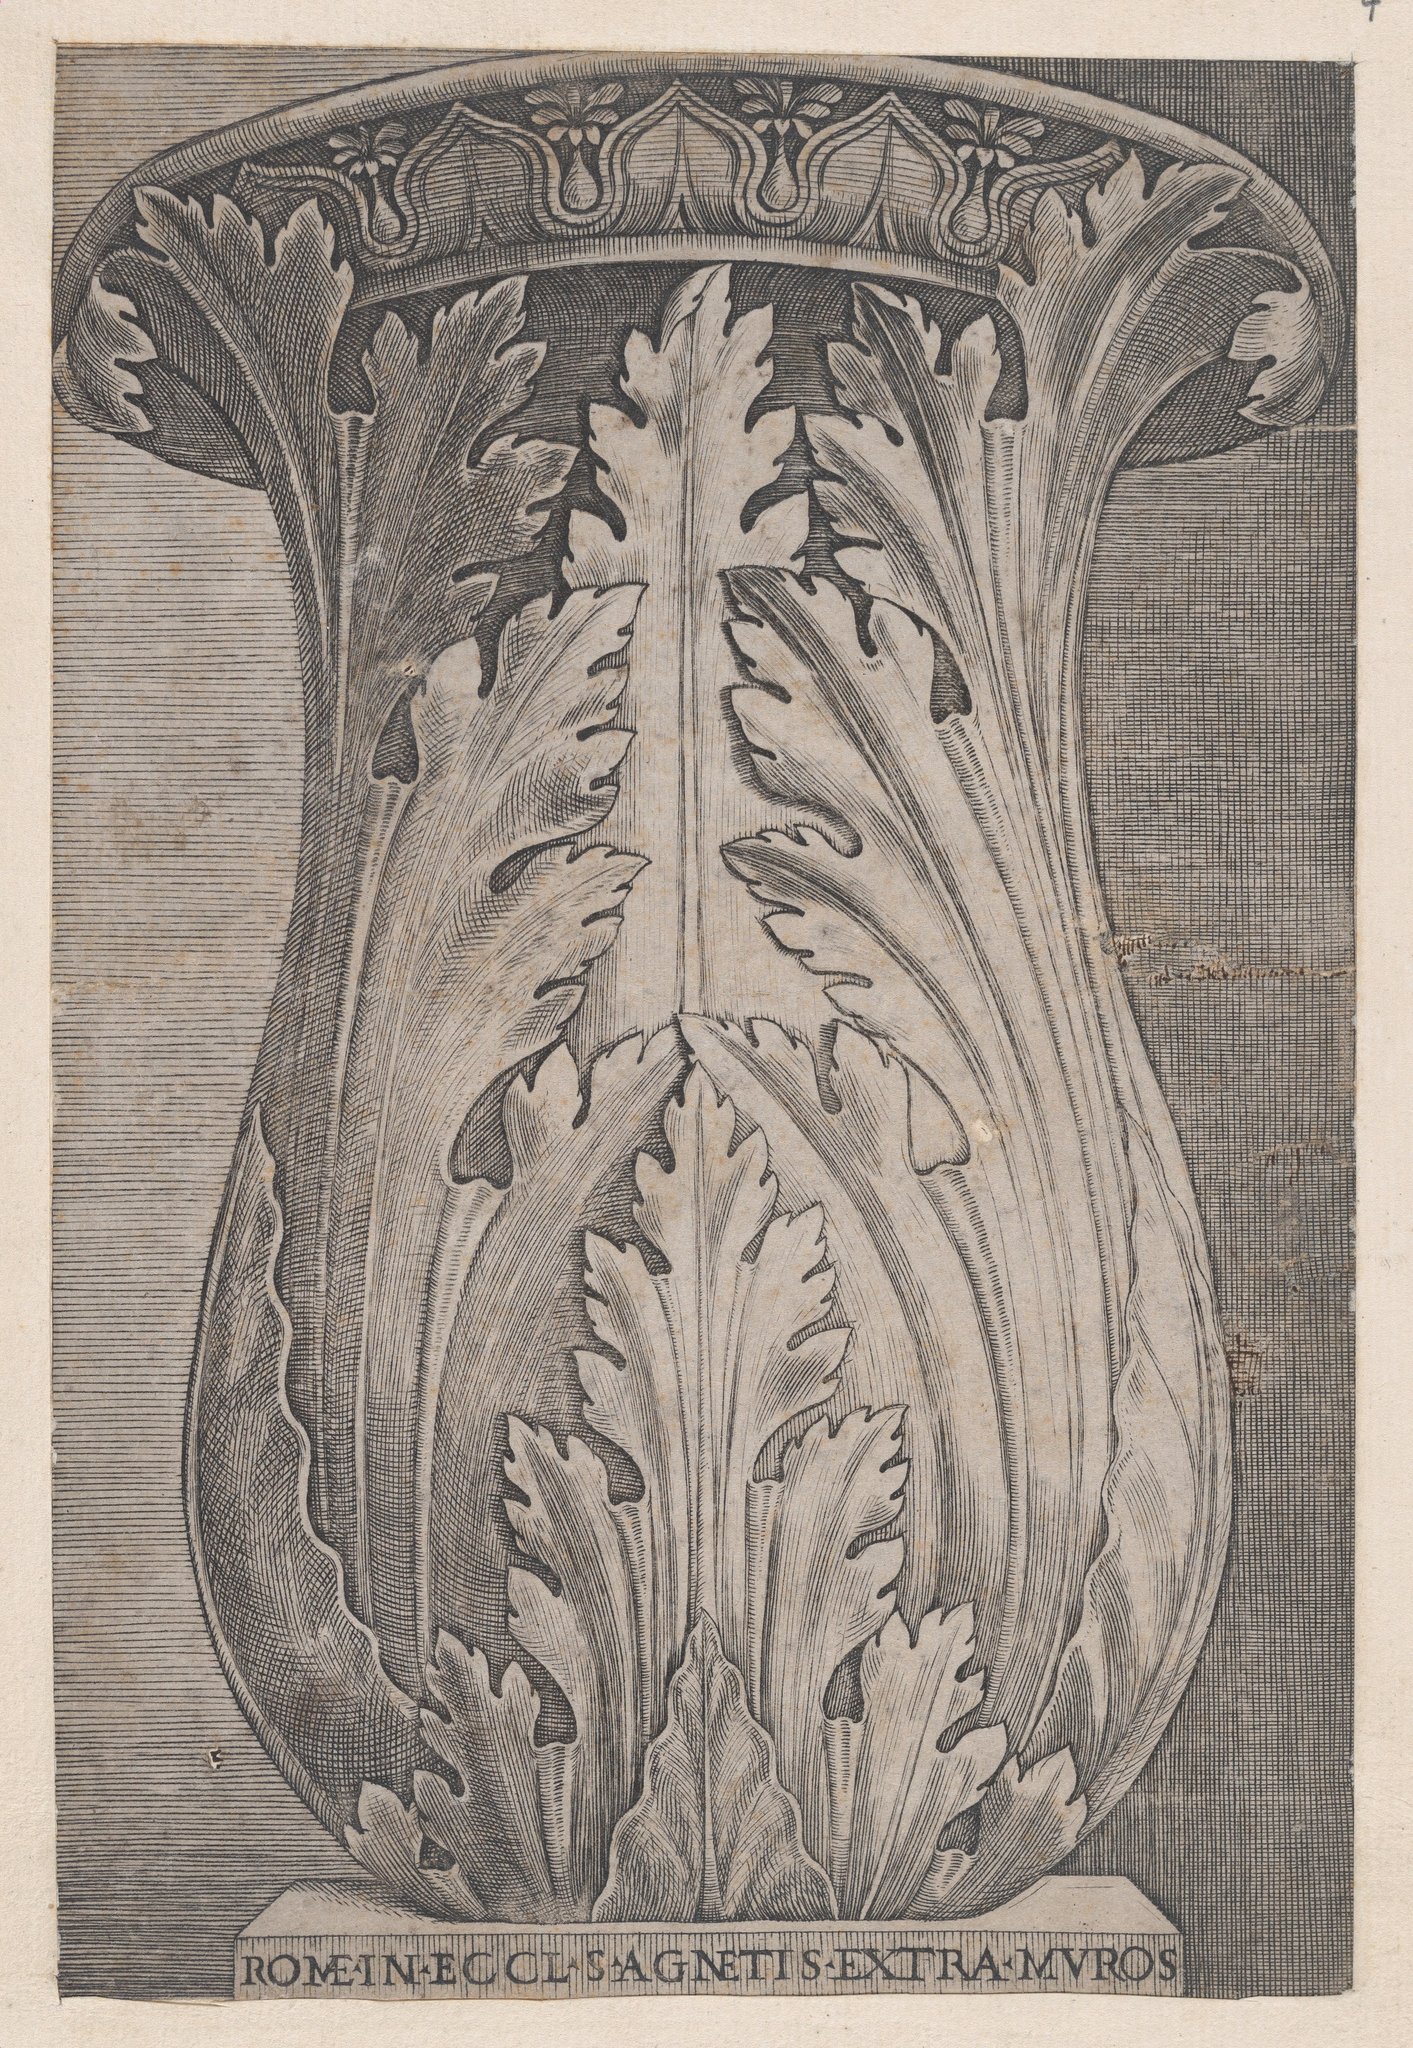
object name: print ornament architecture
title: Capital decorated with Acanthus Leaves from the Church of Sant' Agnese fuori le mura, from "Speculum Romanae Magnificentiae"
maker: agostino veneziano (agostino dei musi)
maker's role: artist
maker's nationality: italian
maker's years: 1490-1536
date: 1514-1536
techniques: engraving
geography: rome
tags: acanthus,vases